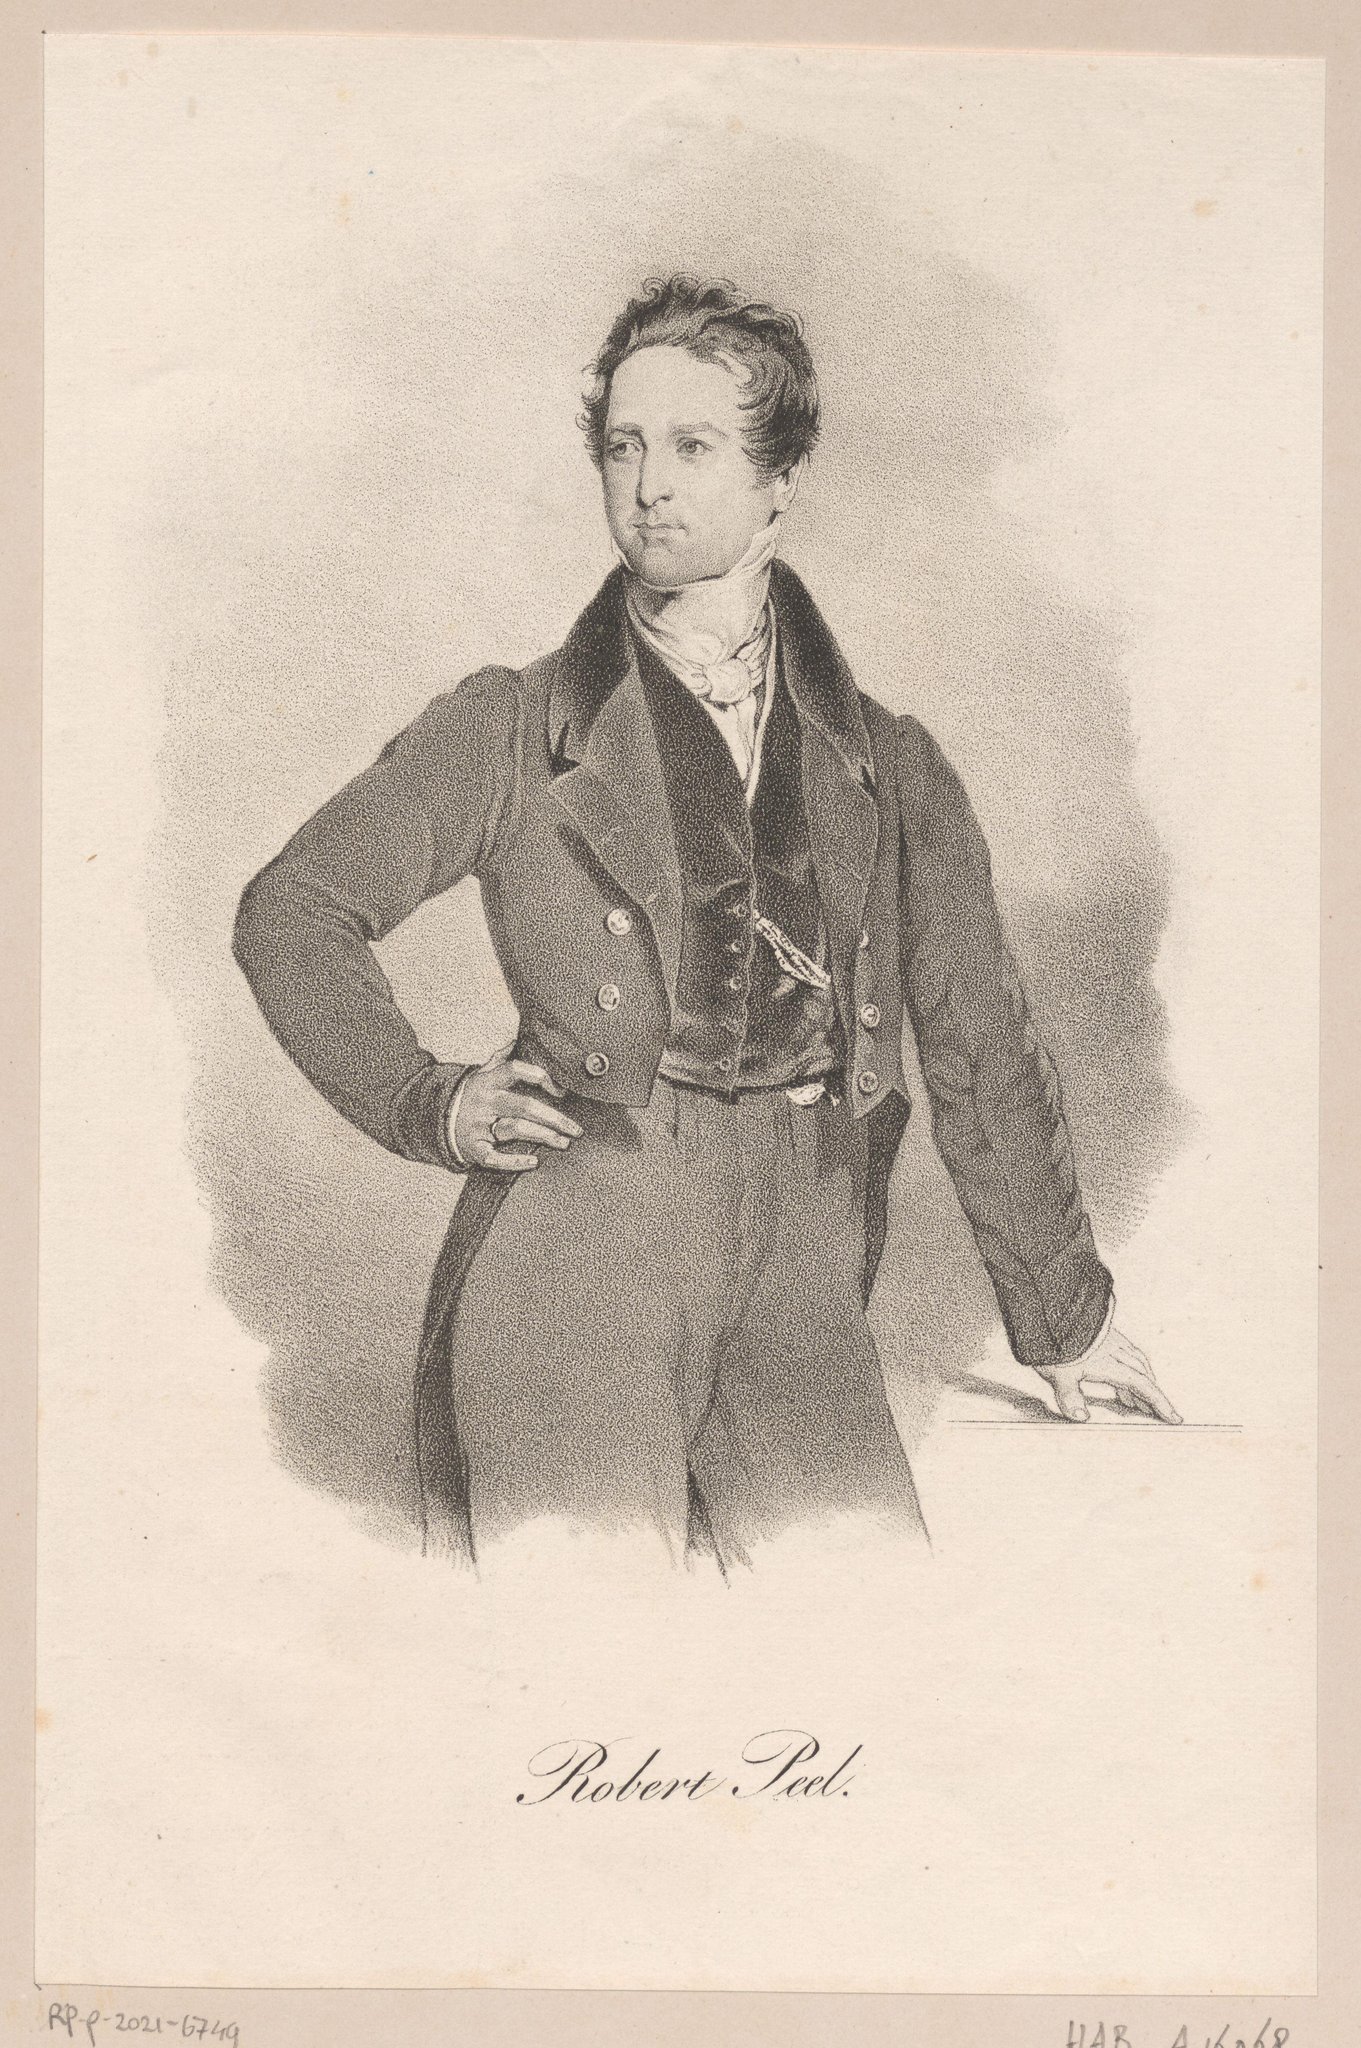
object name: print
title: Portret van Robert Peel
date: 1820-1899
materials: paper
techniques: lithograph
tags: london, adult man, historical persons